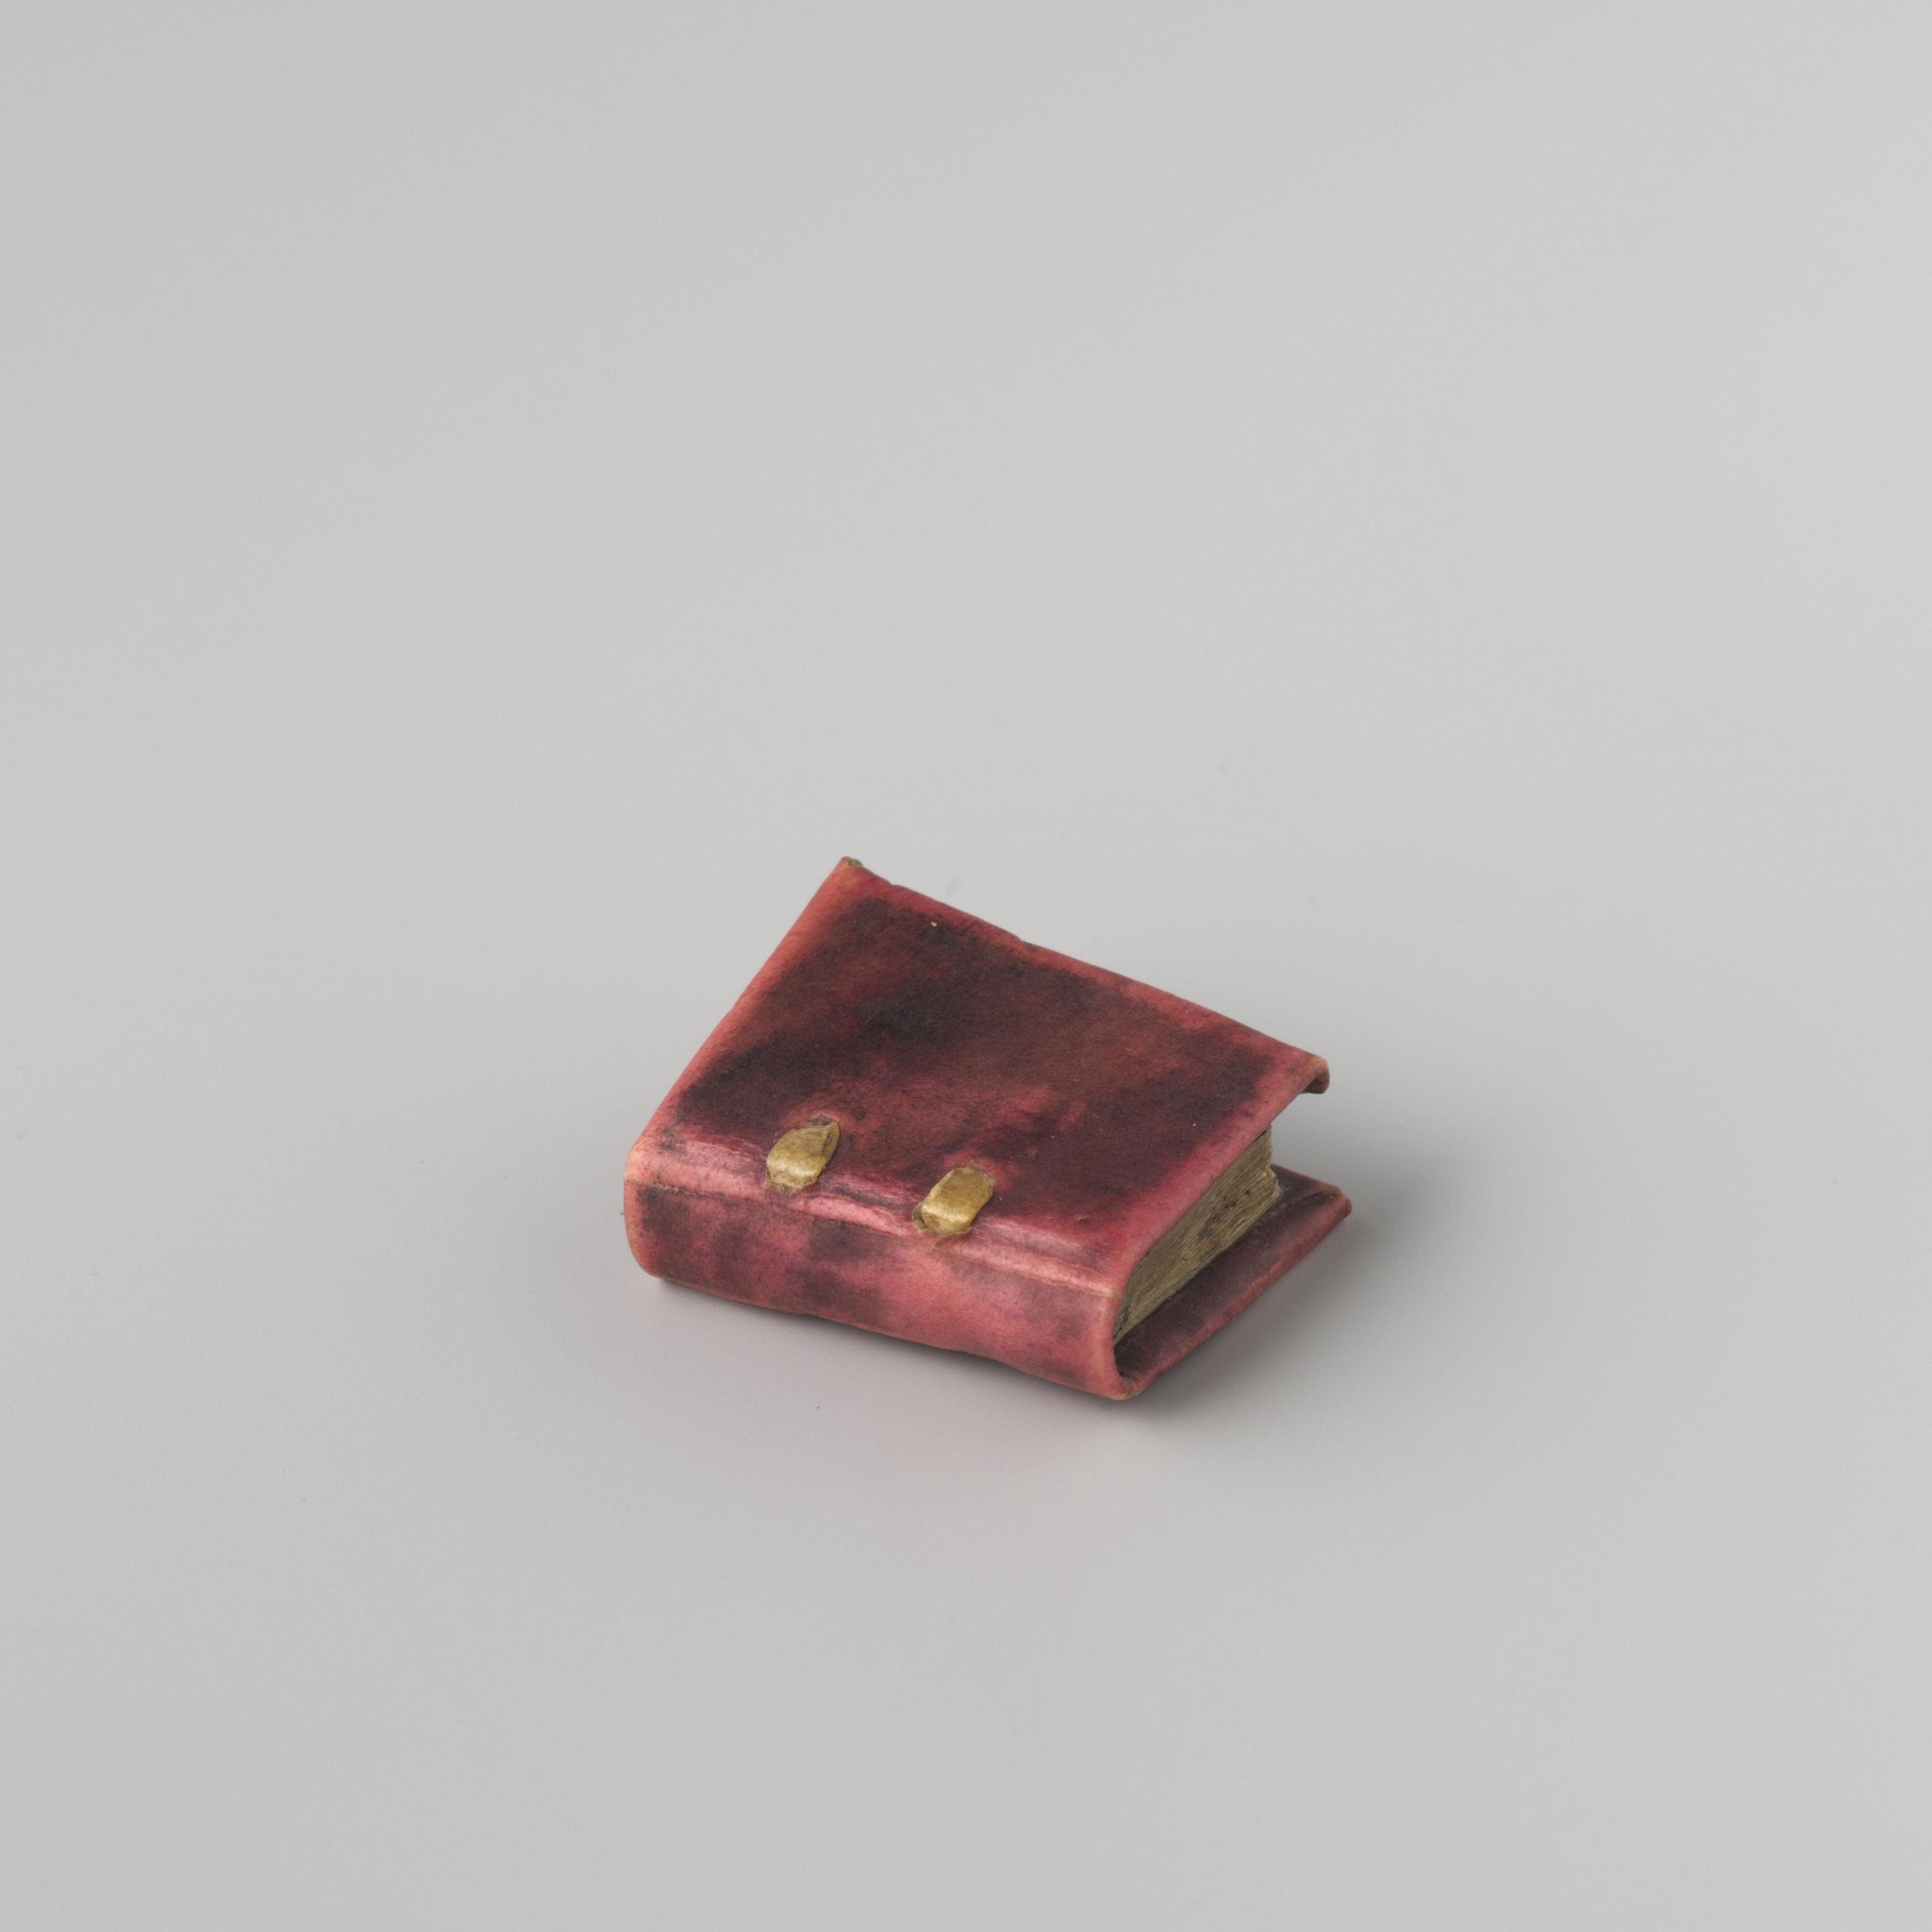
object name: miniature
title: Wapenboek met stadswapens van Gelderse steden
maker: johannes jacobsz van den aveele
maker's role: print maker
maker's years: 1655-1727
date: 1672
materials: paper, parchment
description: Boek, gebonden in roze gekleurd perkament (z.g. splitsel binding), snede groen-bruin gespat; vele katernen van 2 bladen, gevormd door uitgeknipte en deels aan een kim of plakstrook van het vooraf aan de blad aangehechte, ingekleurde stadswapens: Geldersche Steden (14 stuks).